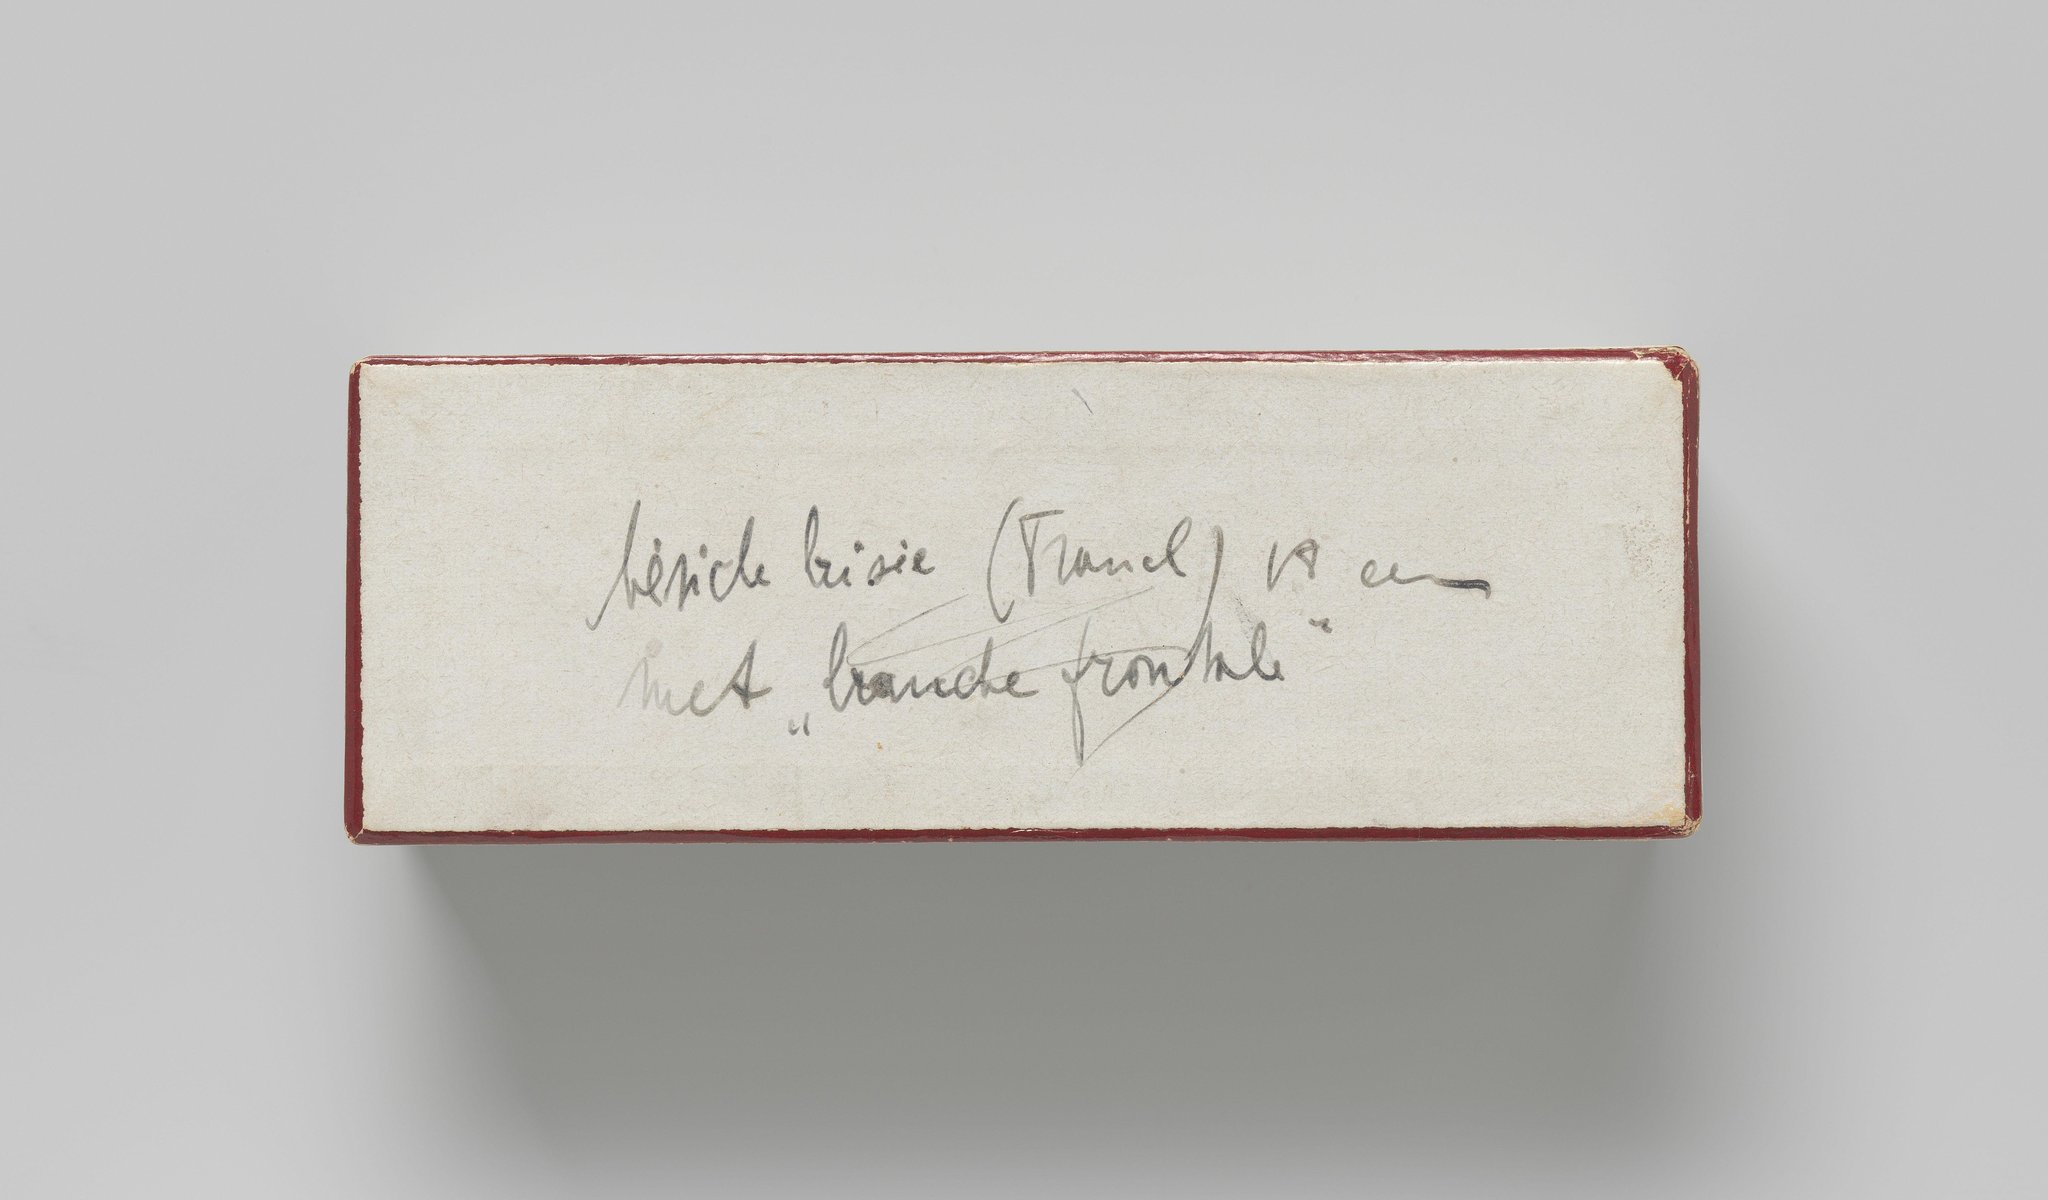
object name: packing material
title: Doos met deksel van karton beplakt met wit papier afkomstig van de juwelier F. Wessel te Rotterdam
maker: Anonymous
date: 1880-1940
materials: cardboard, paper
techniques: pasting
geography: europe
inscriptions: label: ‘F.Wessel / Juwelier - Horloger / KIPSTRAAT 105 / o. d. Stadhuissteeg / ROTTERDAM / Telefoon 10481’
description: Doos met deksel van karton beplakt met wit papier afkomstig van de juwelier F. Wessel te Rotterdam, gevuld met watten.